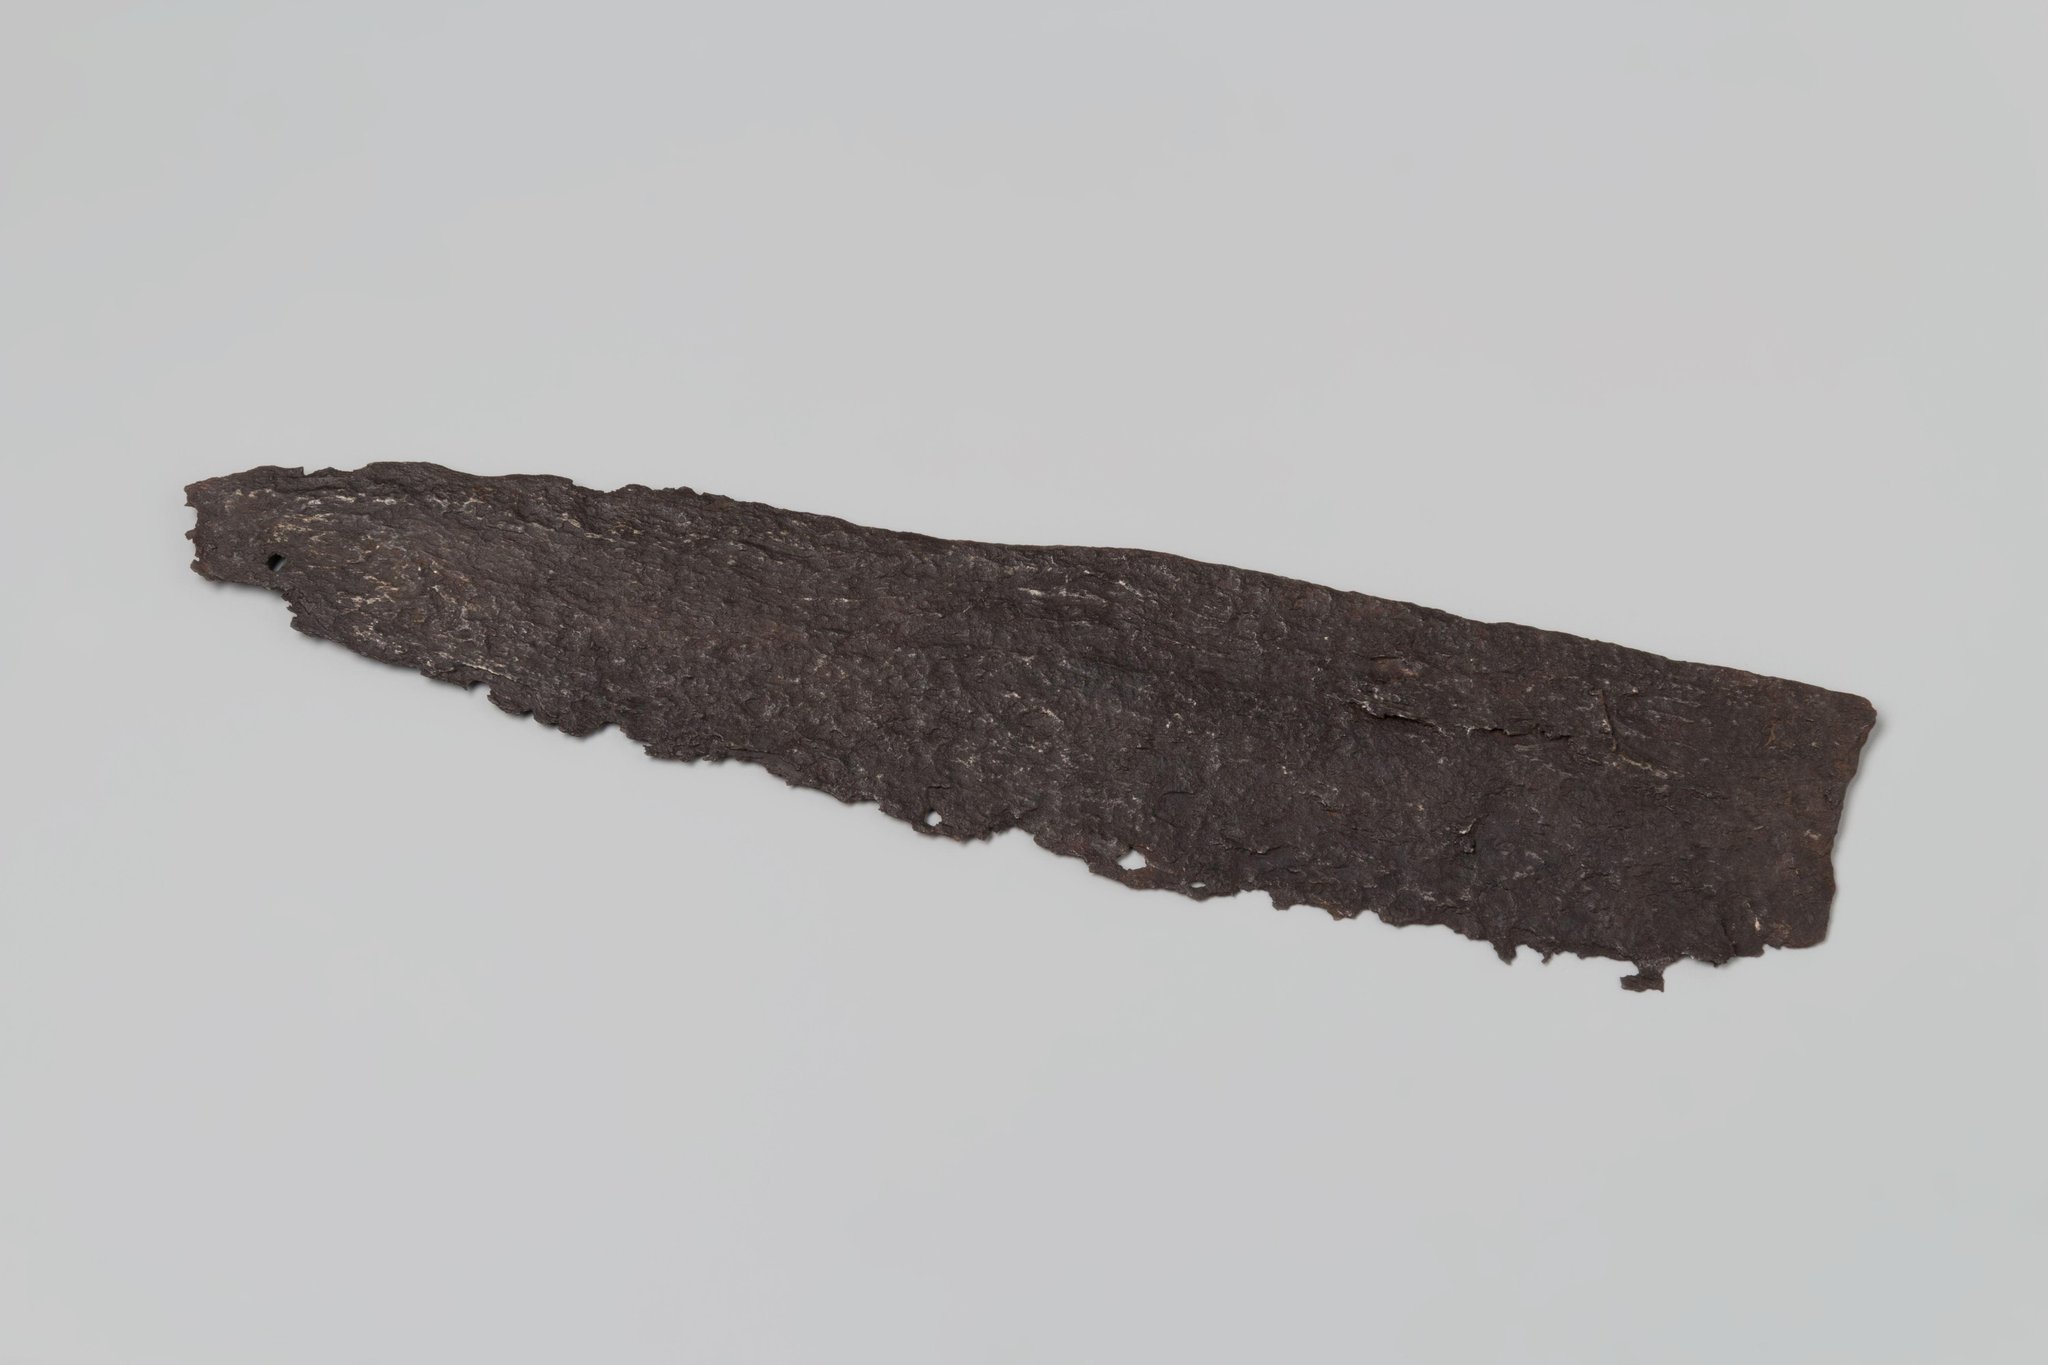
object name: knife tool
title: Fragment van het lemmet van een strandsnijdersmes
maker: Anonymous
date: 1400-1950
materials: iron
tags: zeeuwsche uytkyck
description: Het bovenste gedeelte van het lemmet van een strandsnijdersmes.